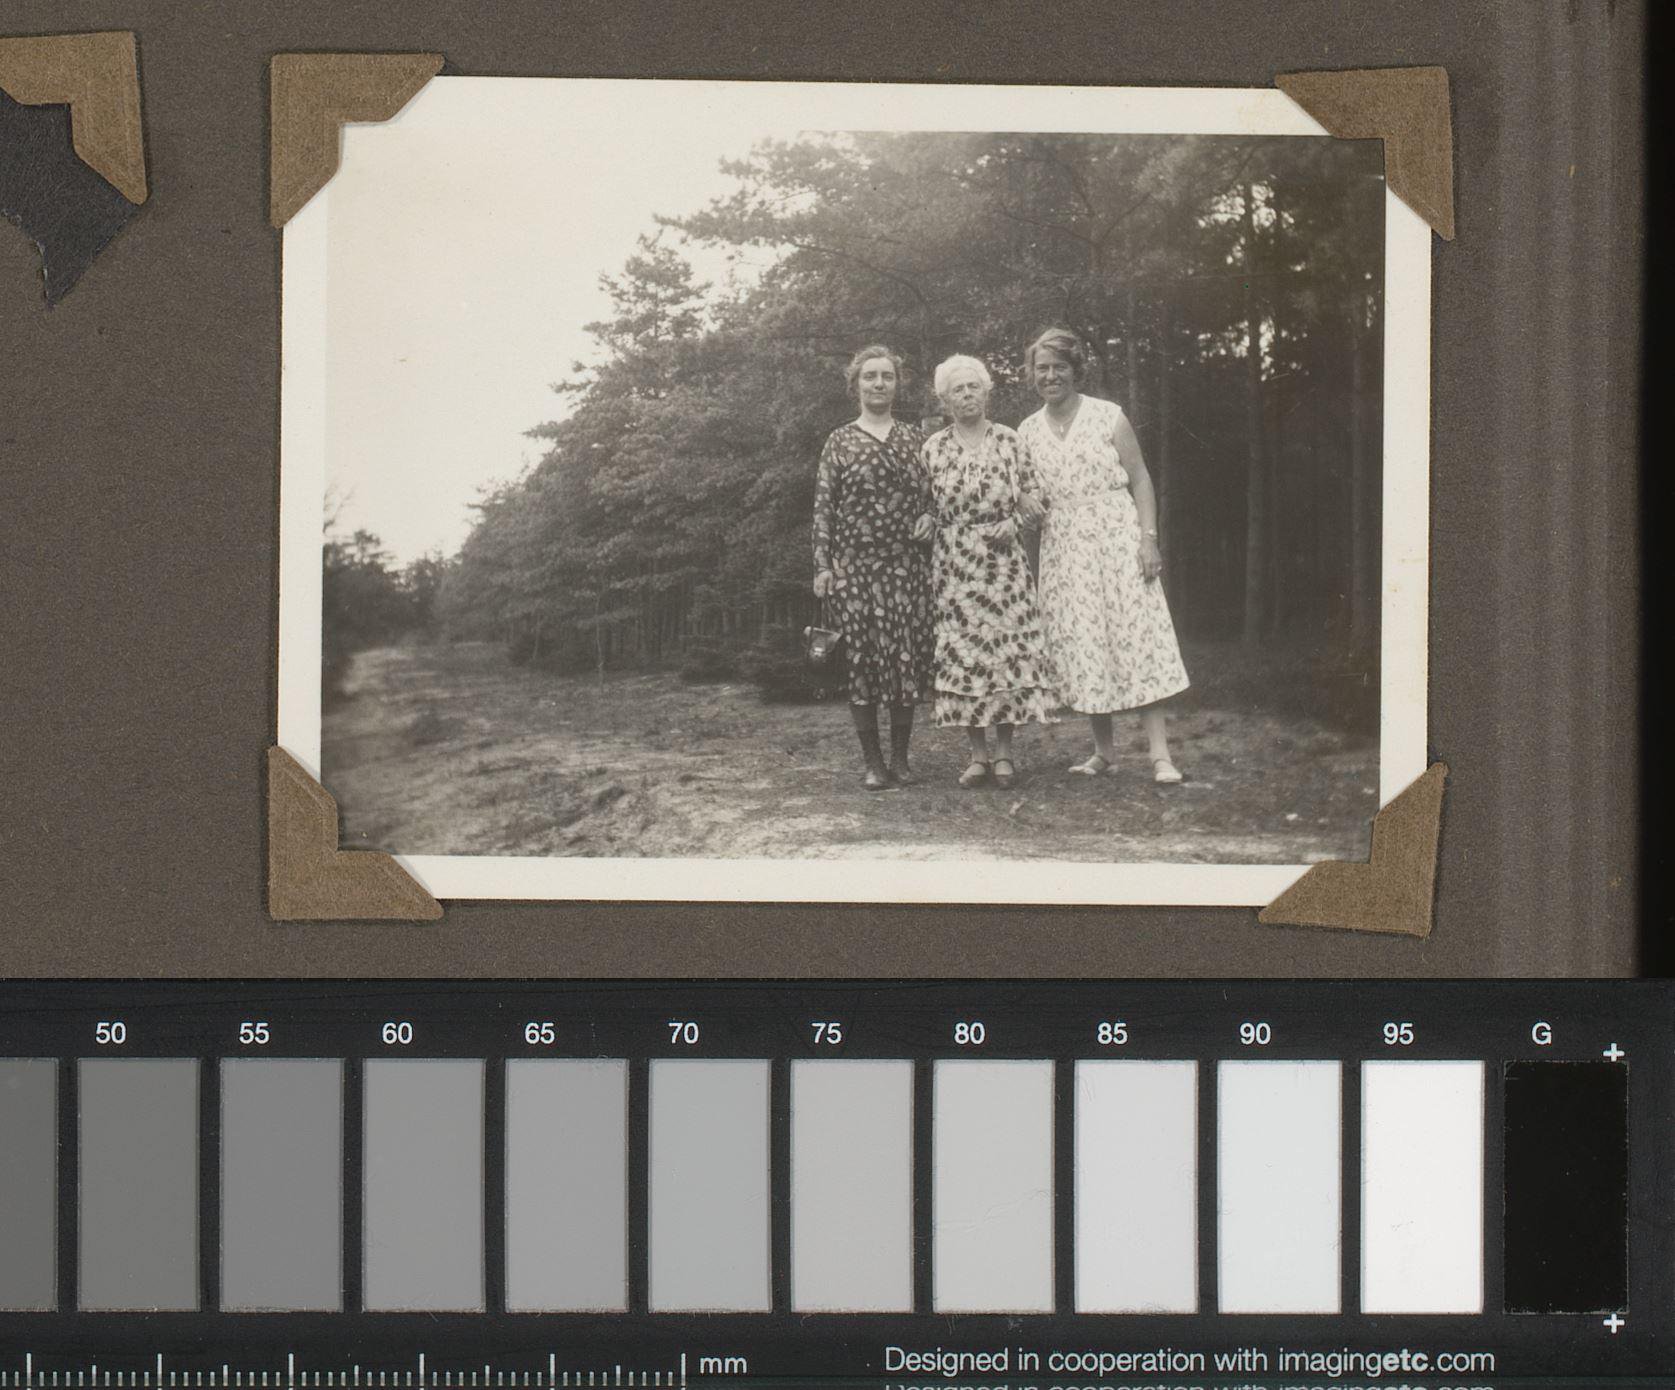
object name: album leaf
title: Portret van drie vrouwen in jurken met patronen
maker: Anonymous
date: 1920-1940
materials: photographic support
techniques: gelatin silver print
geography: netherlands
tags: historical persons, forest, wood, adult woman (+ three persons)